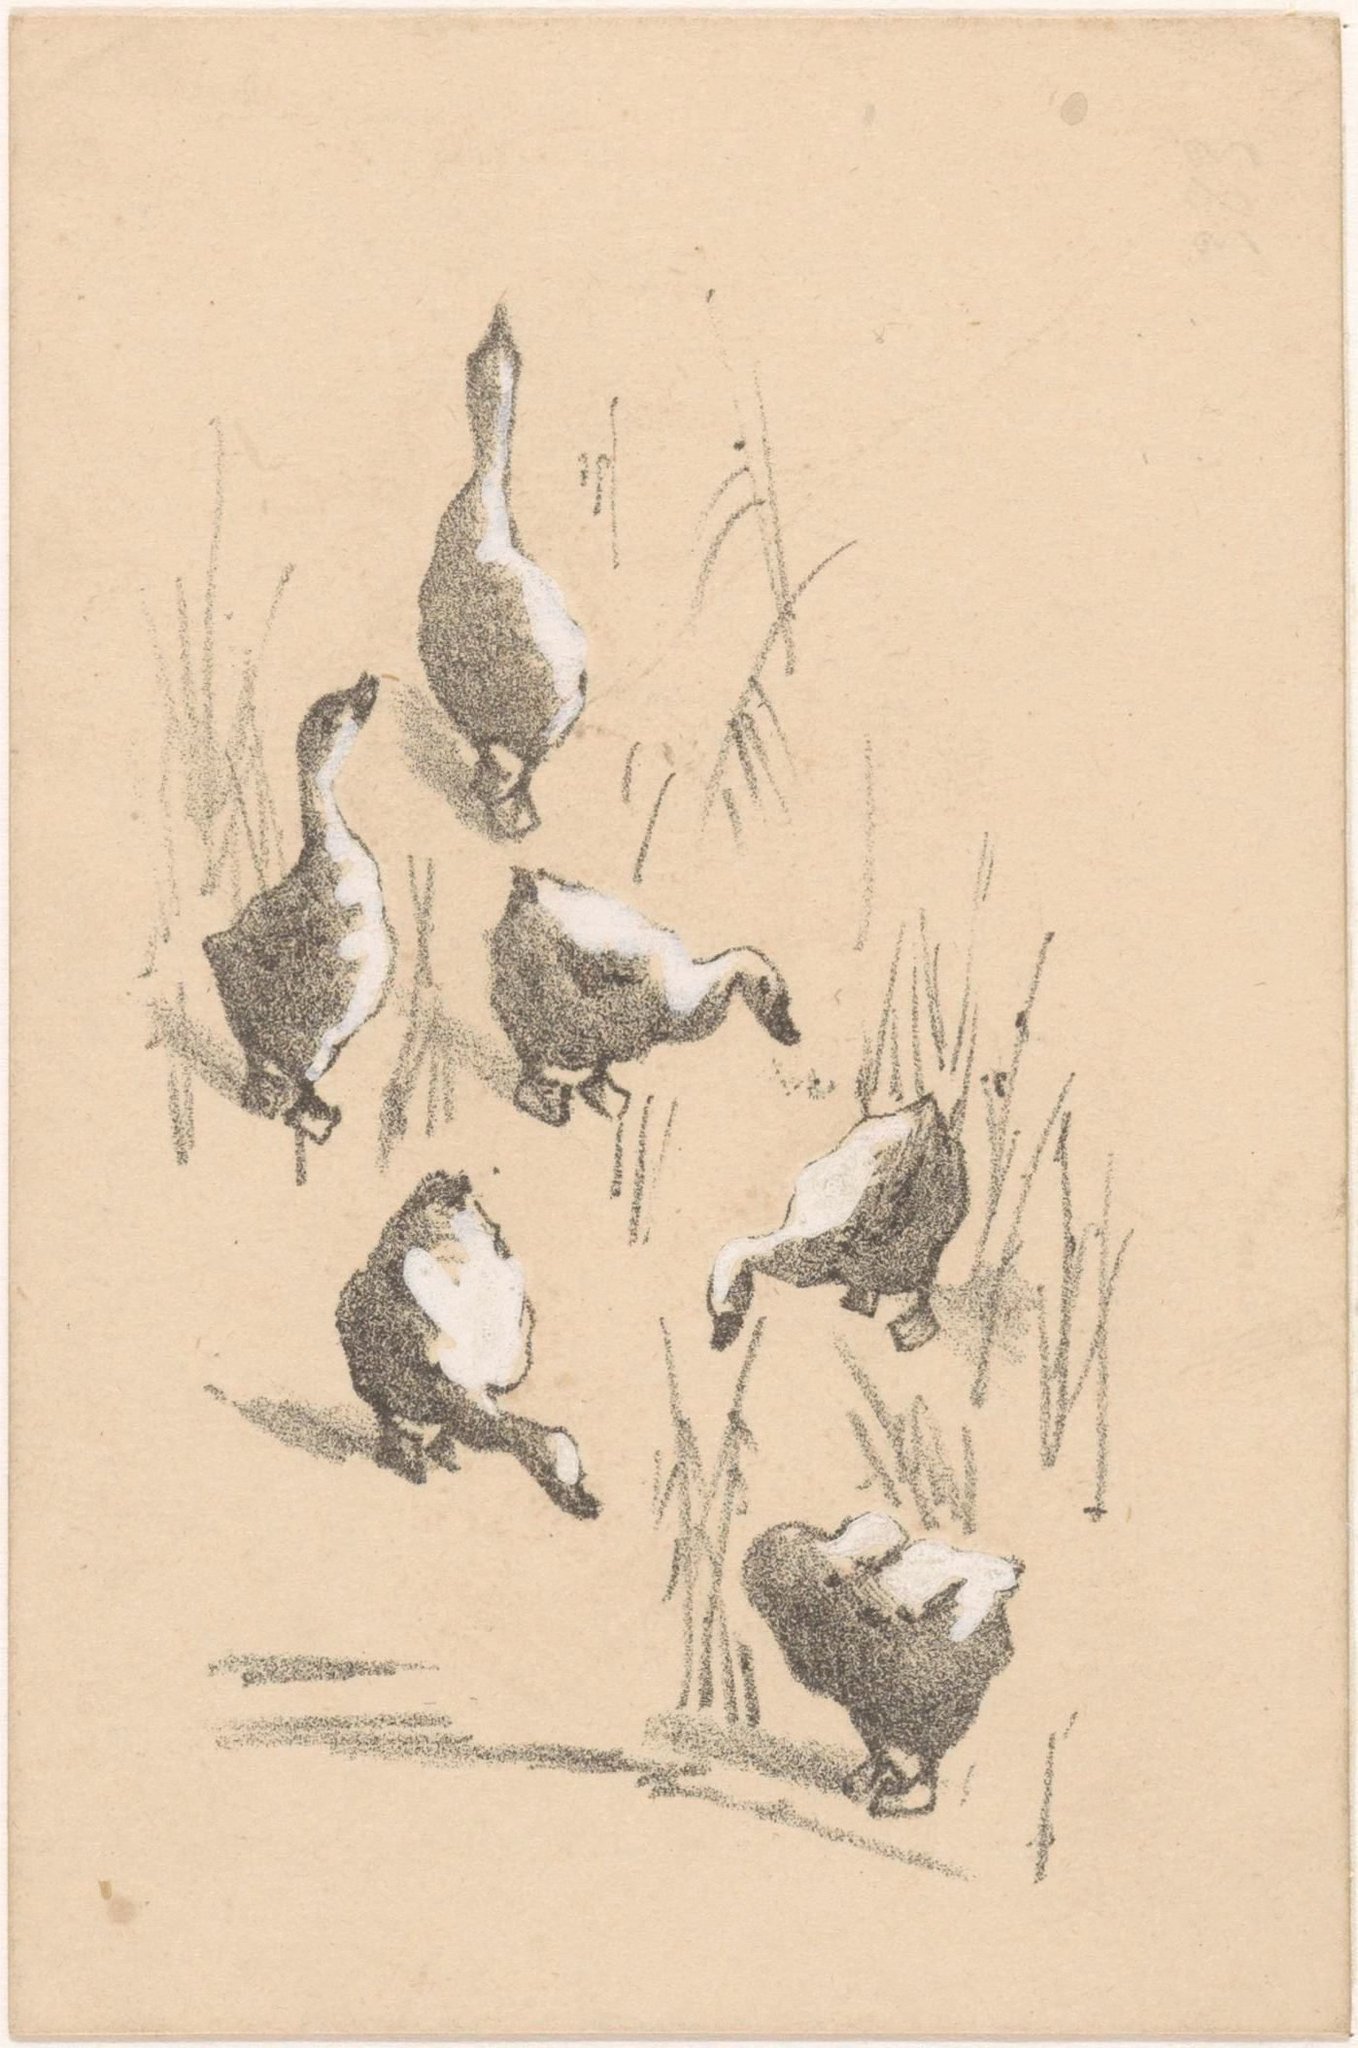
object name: print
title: Wenskaart met zes ganzen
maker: theo van hoytema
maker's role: draughtsman, painter, print maker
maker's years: 1863-1917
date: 1878-1917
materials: paper, watercolor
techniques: hand coloring, lithograph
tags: geese (domestic waterbirds)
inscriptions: collector's mark: Lugt 2228